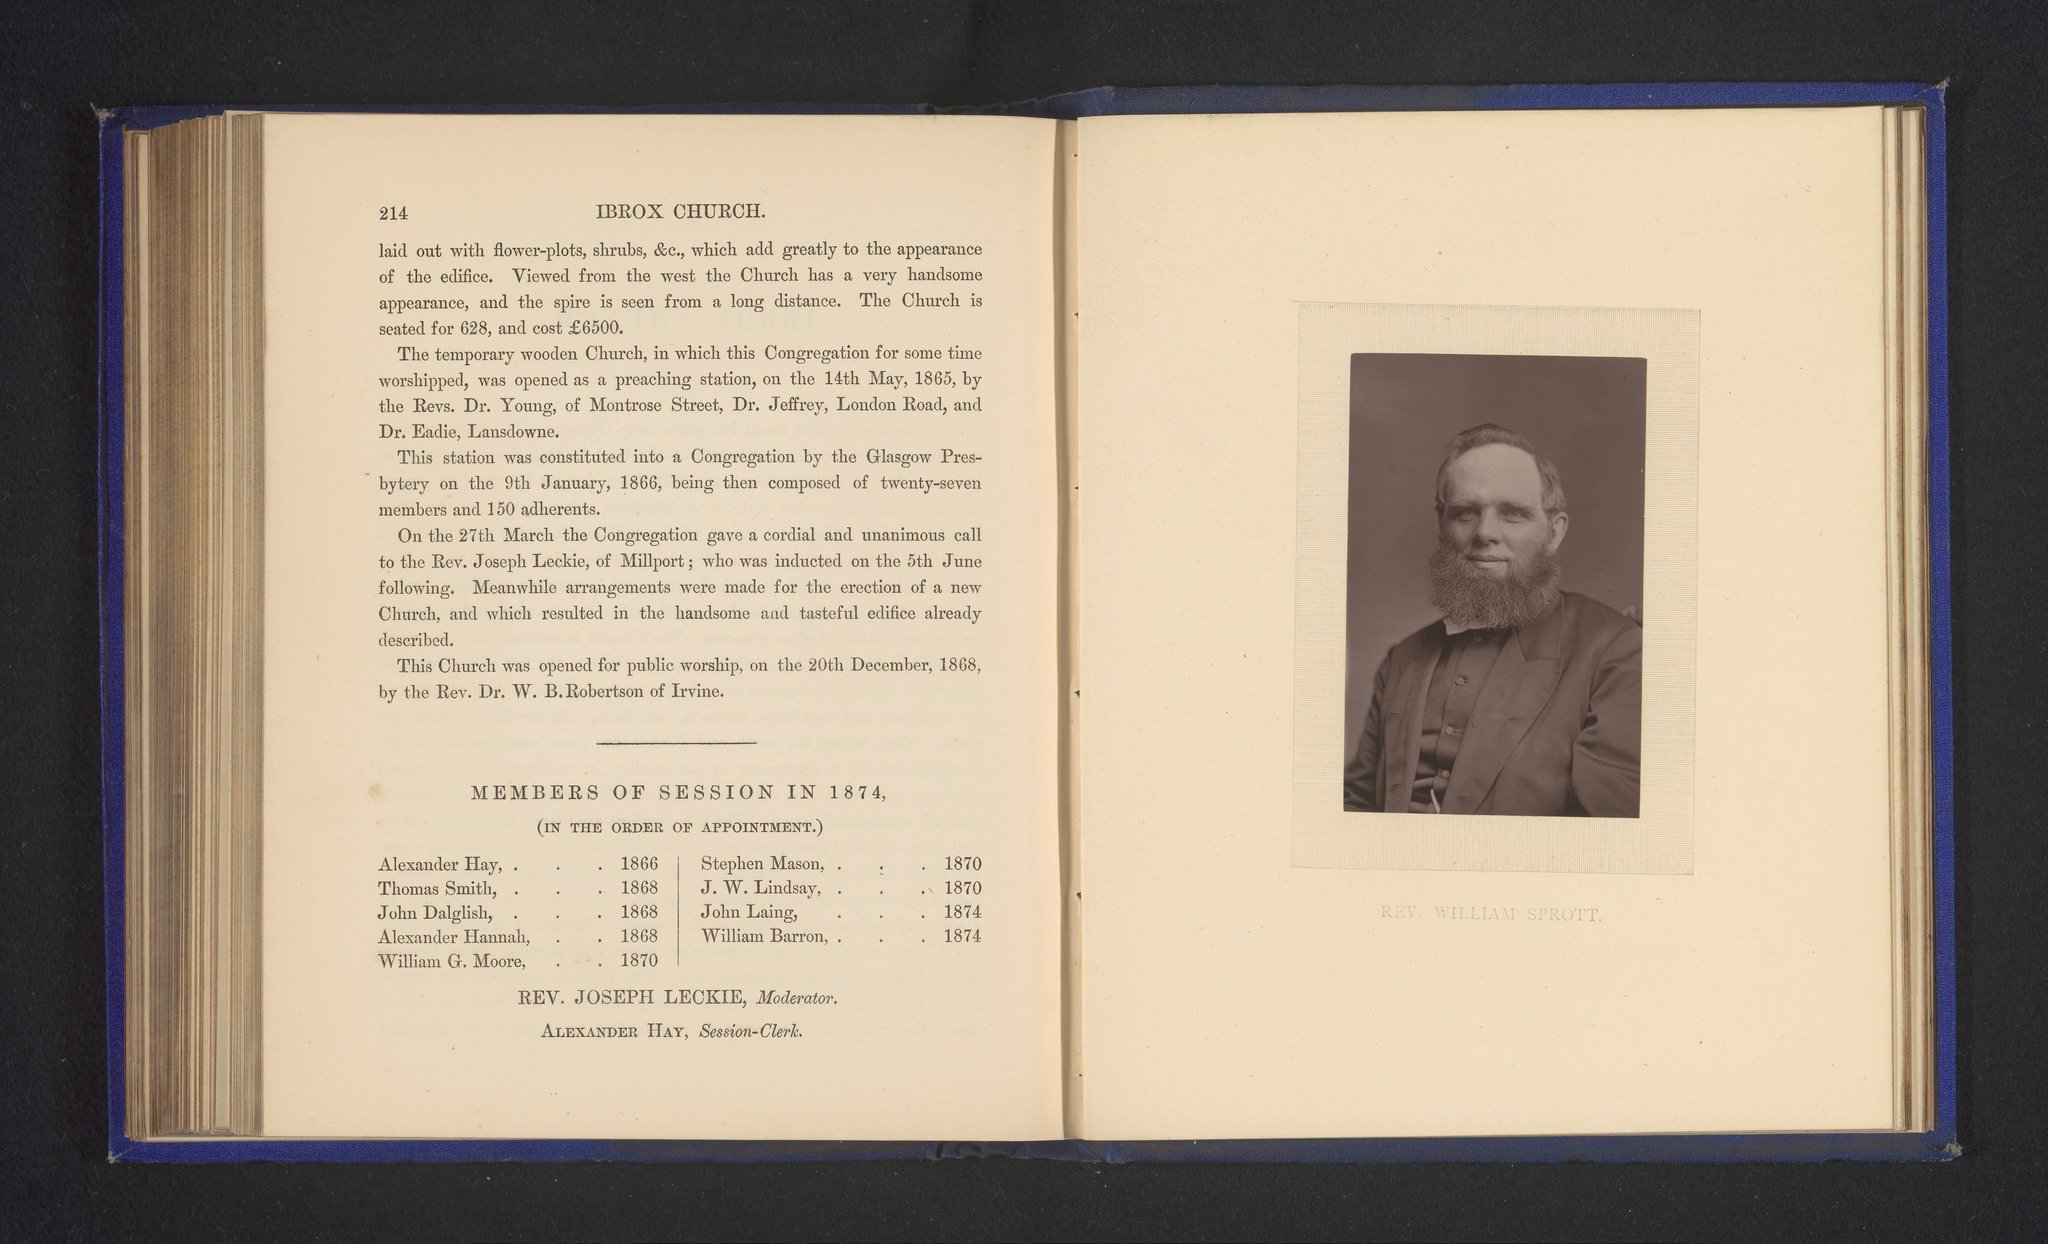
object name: page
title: Rev. William Sprott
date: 1867-1875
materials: paper, photographic support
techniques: carbon print, woodburytype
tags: functionaries and dignitaries (with name) ~ protestant churches